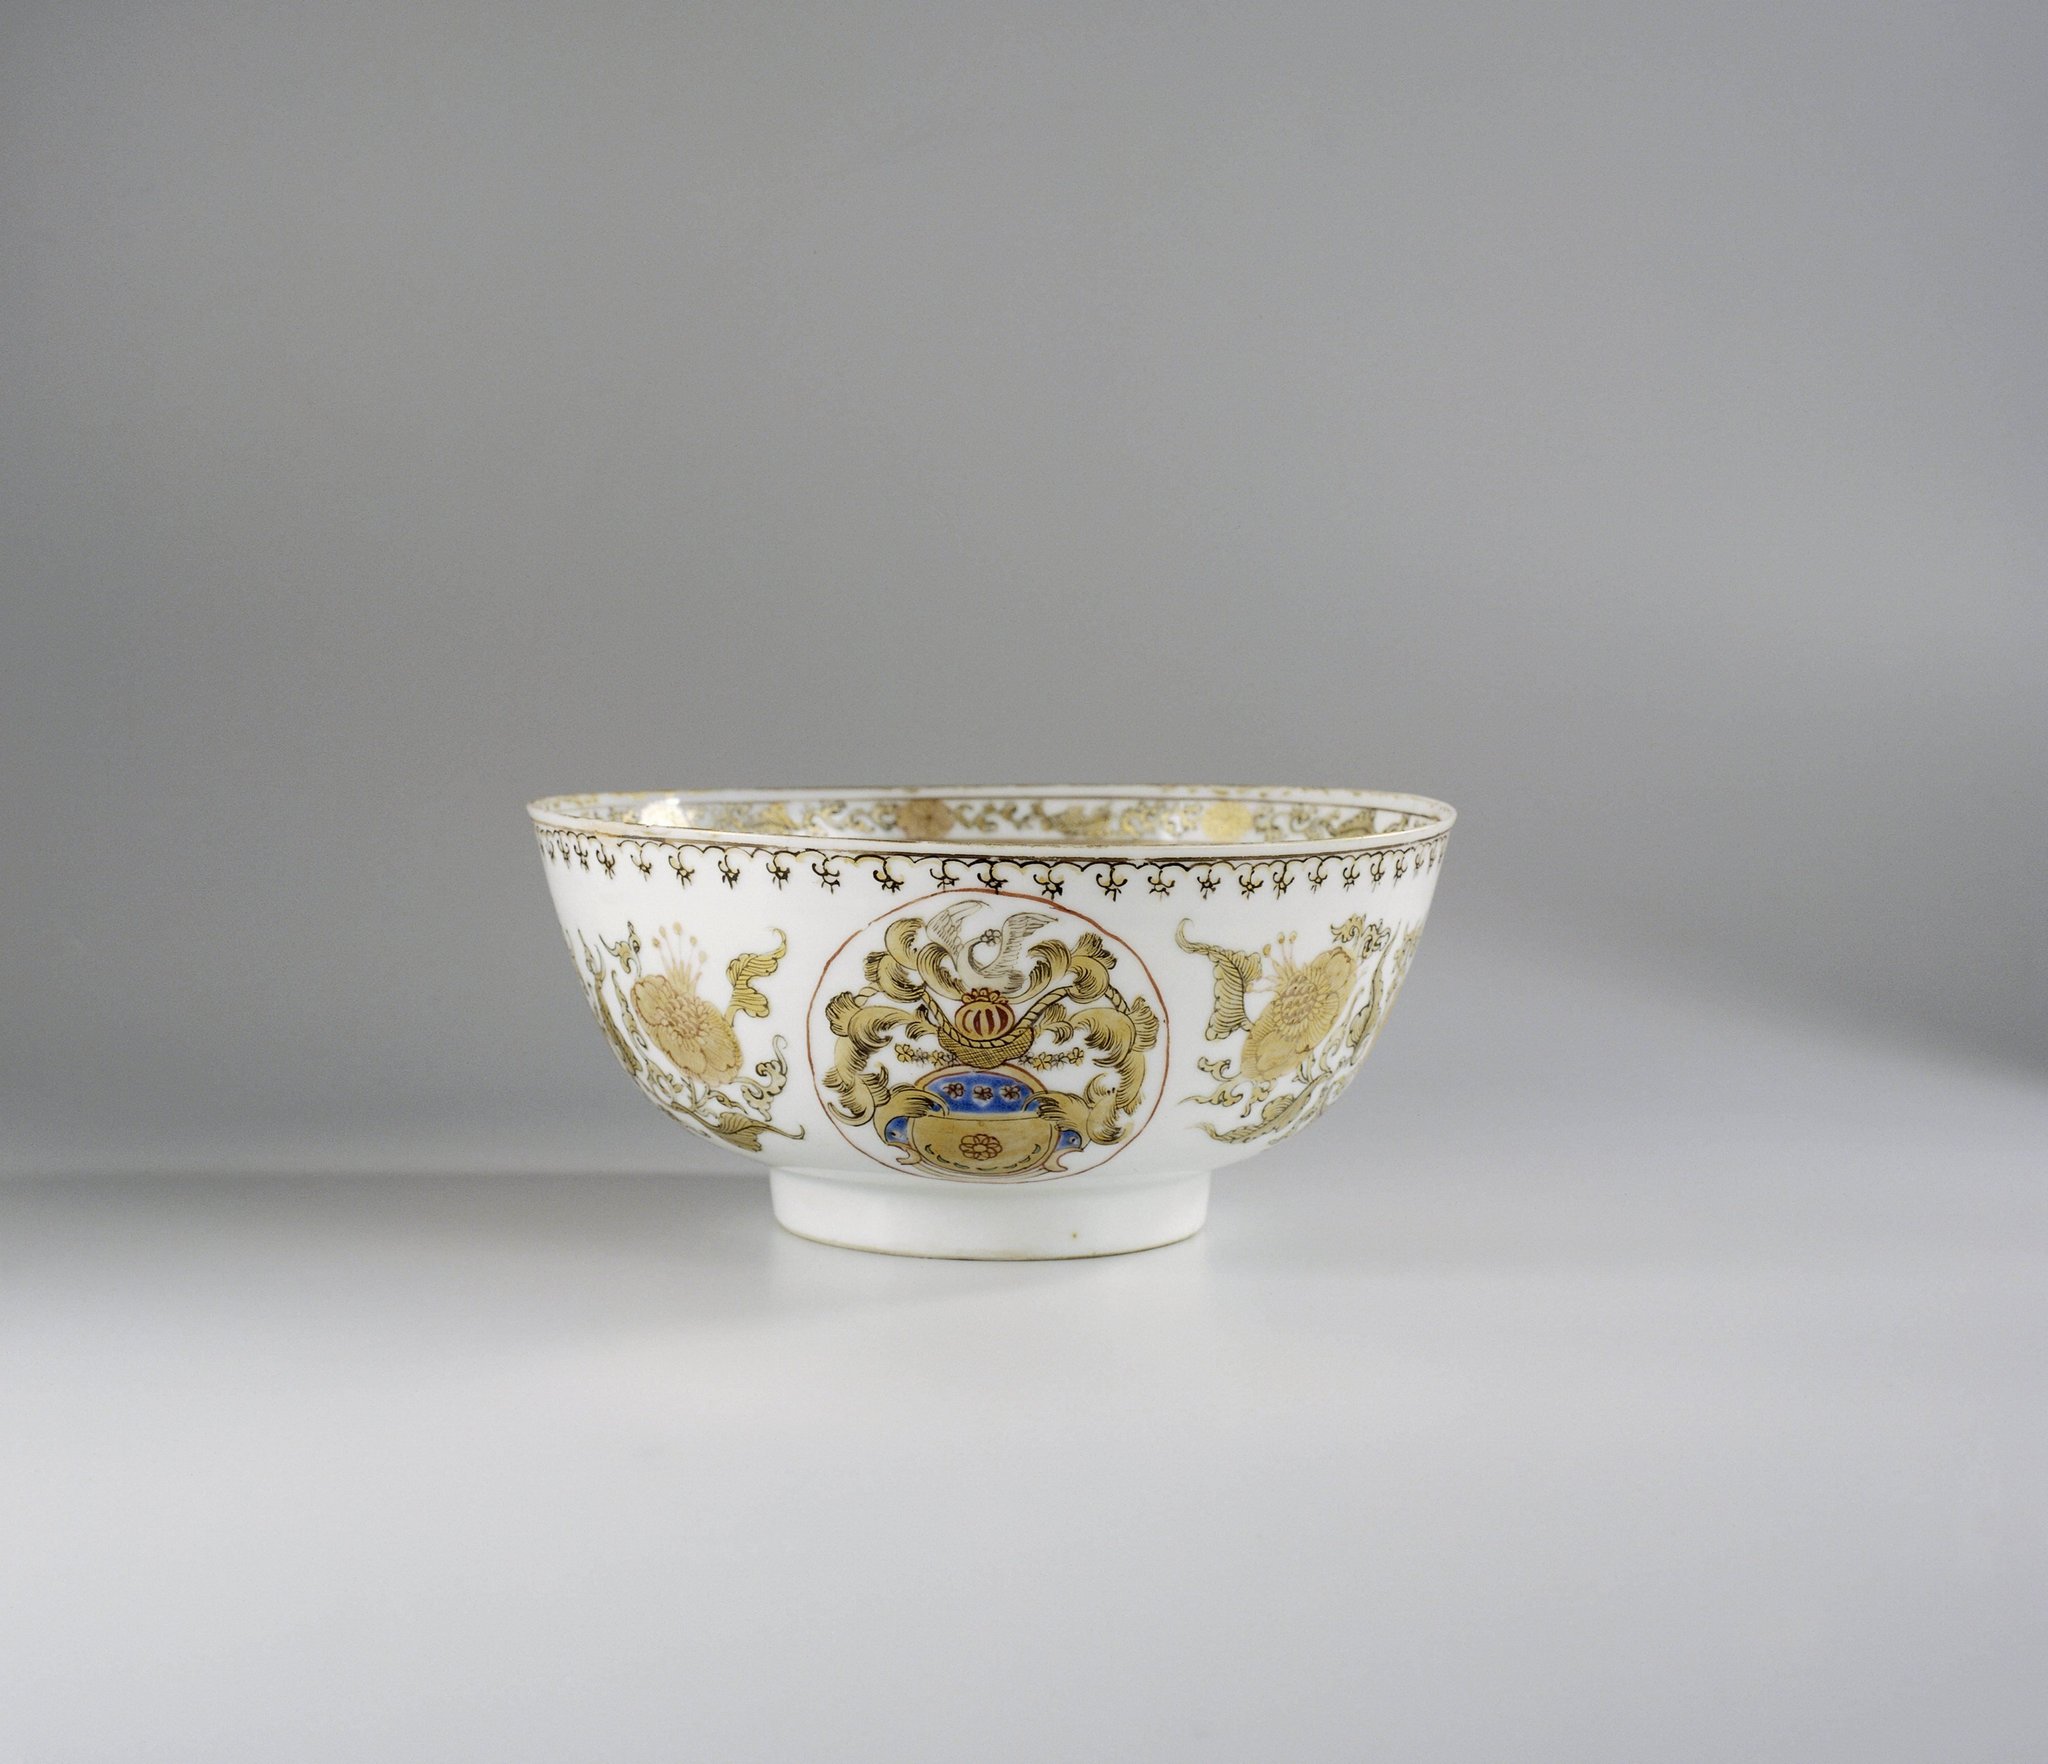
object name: bowl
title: Straight-sided bowl with a coat of arms and flower scrolls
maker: Anonymous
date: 1725-1749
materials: glaze, gold, paint, porcelain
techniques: firing, gilding, turning, vitrification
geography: china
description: Kom, beschilderd in encre de Chine, emails en goud met twee maal een medaillon met een familiewapen en met bloemtakken. Langs de buitenrand een spearhead-rand, langs de binnerand een decoratieve band.